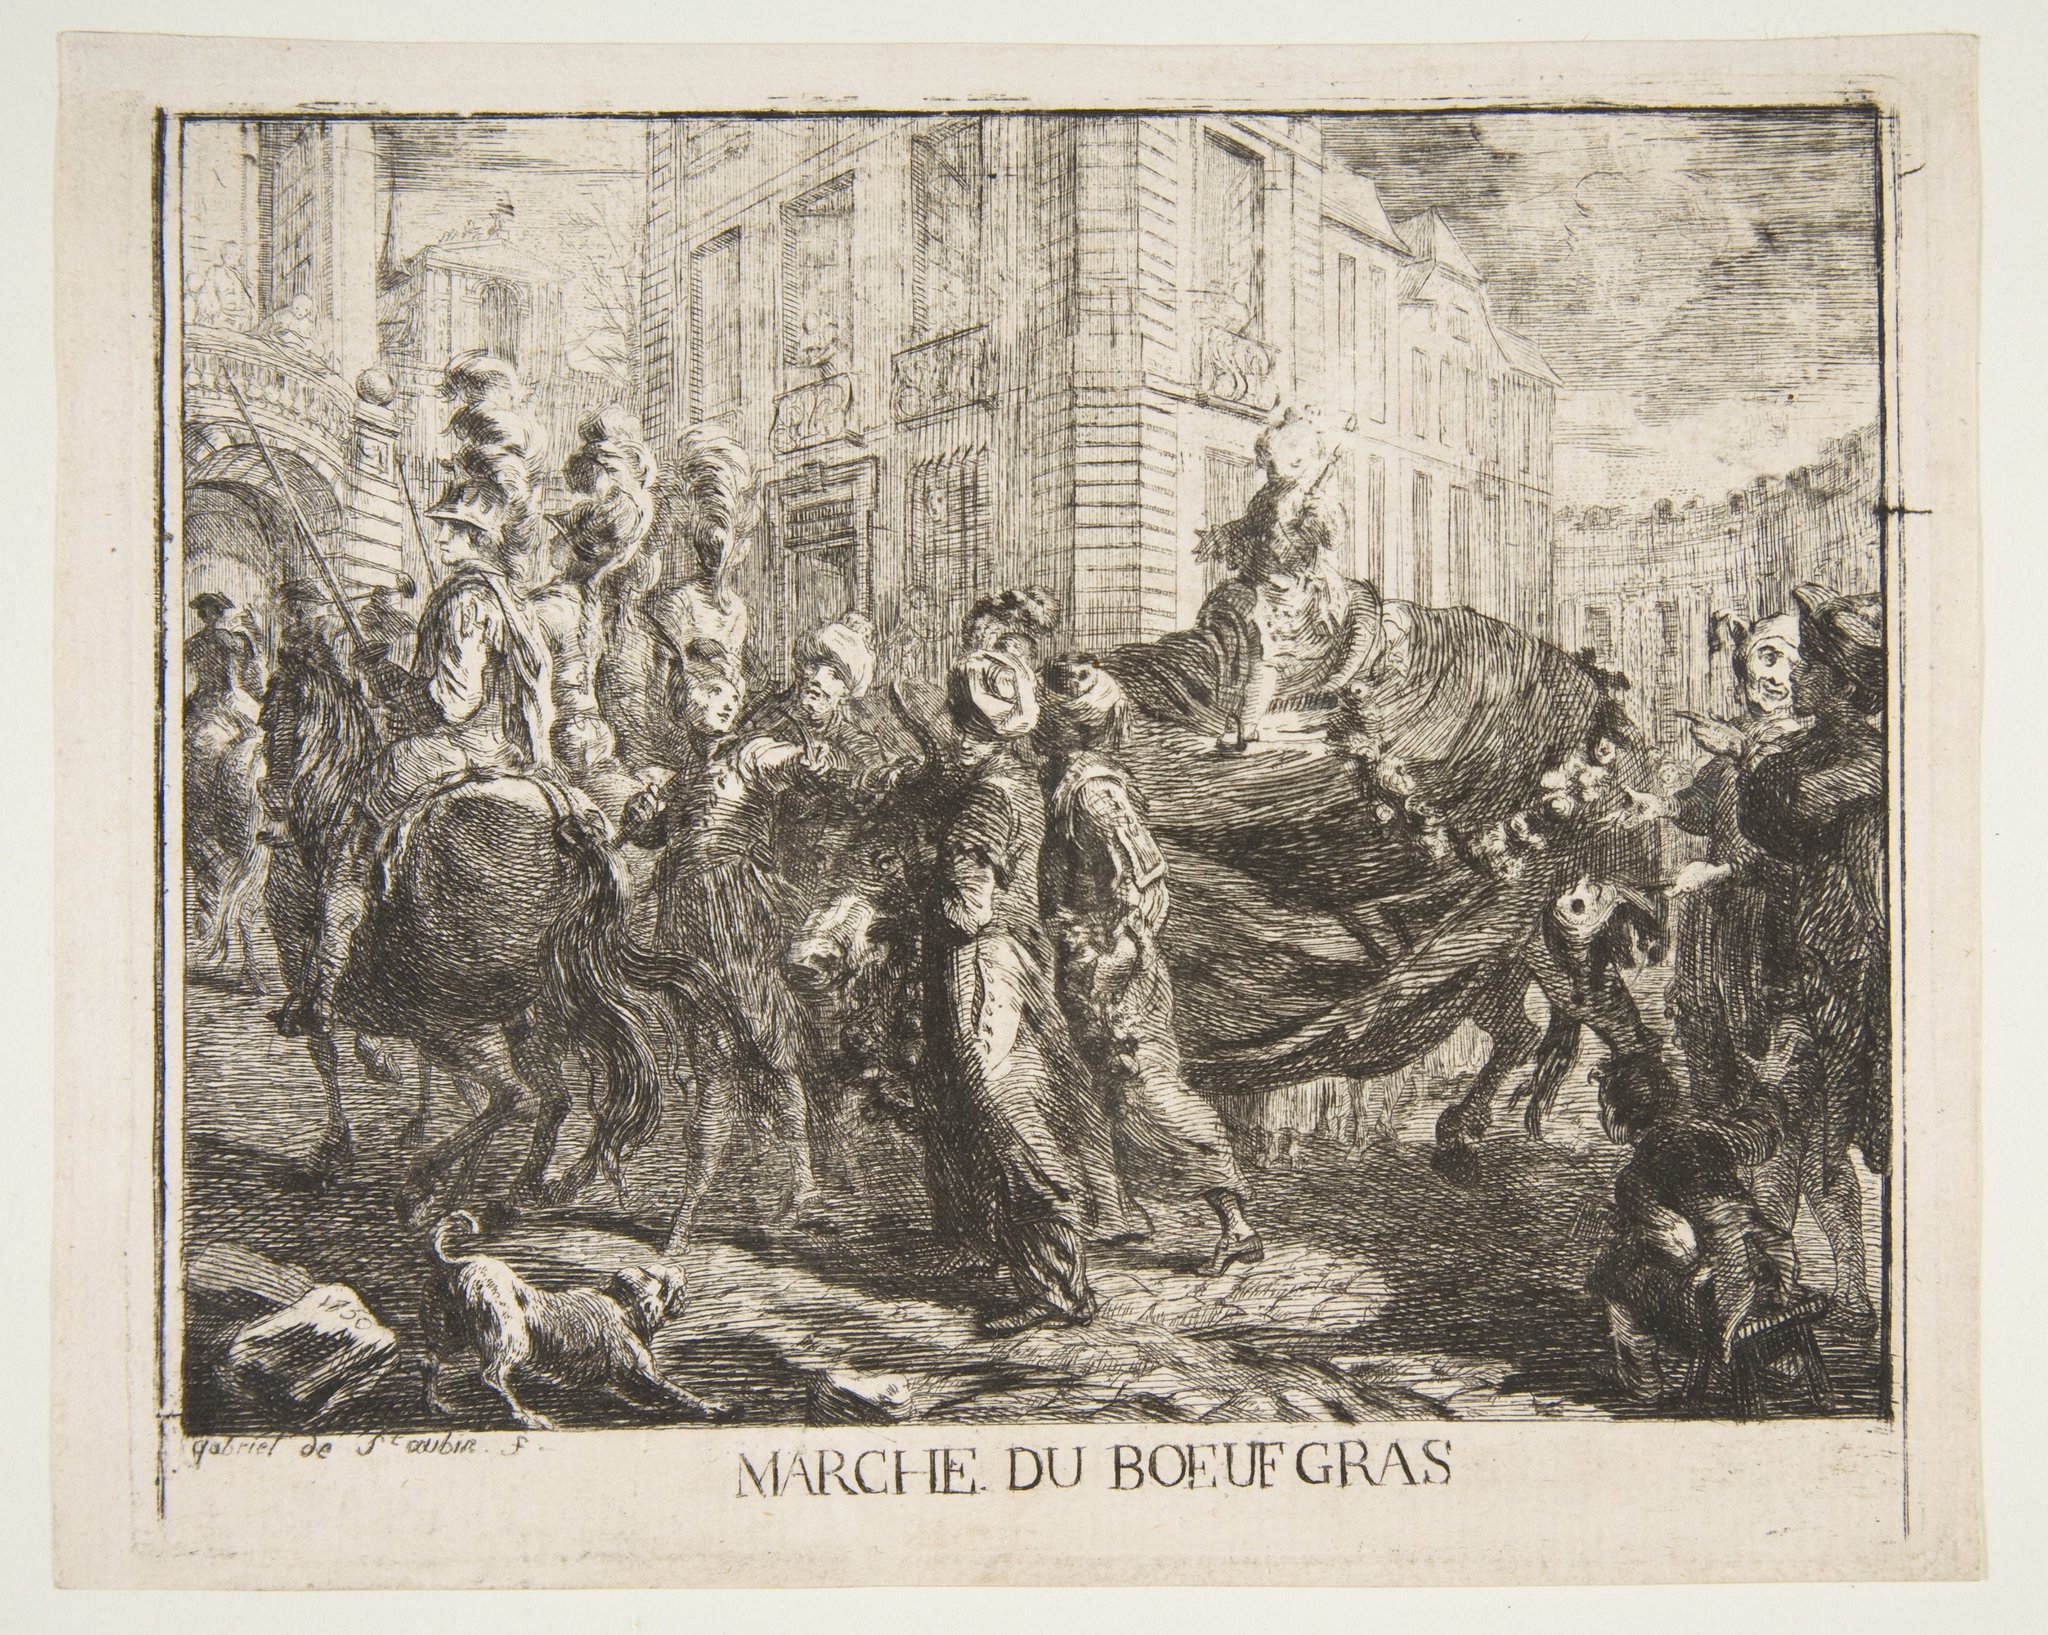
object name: print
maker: gabriel de saint-aubin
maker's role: artist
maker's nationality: french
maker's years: 1724-1780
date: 1750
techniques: etching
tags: buildings,soldiers,swords,women,bulls,dogs,horses,crowd,street scene